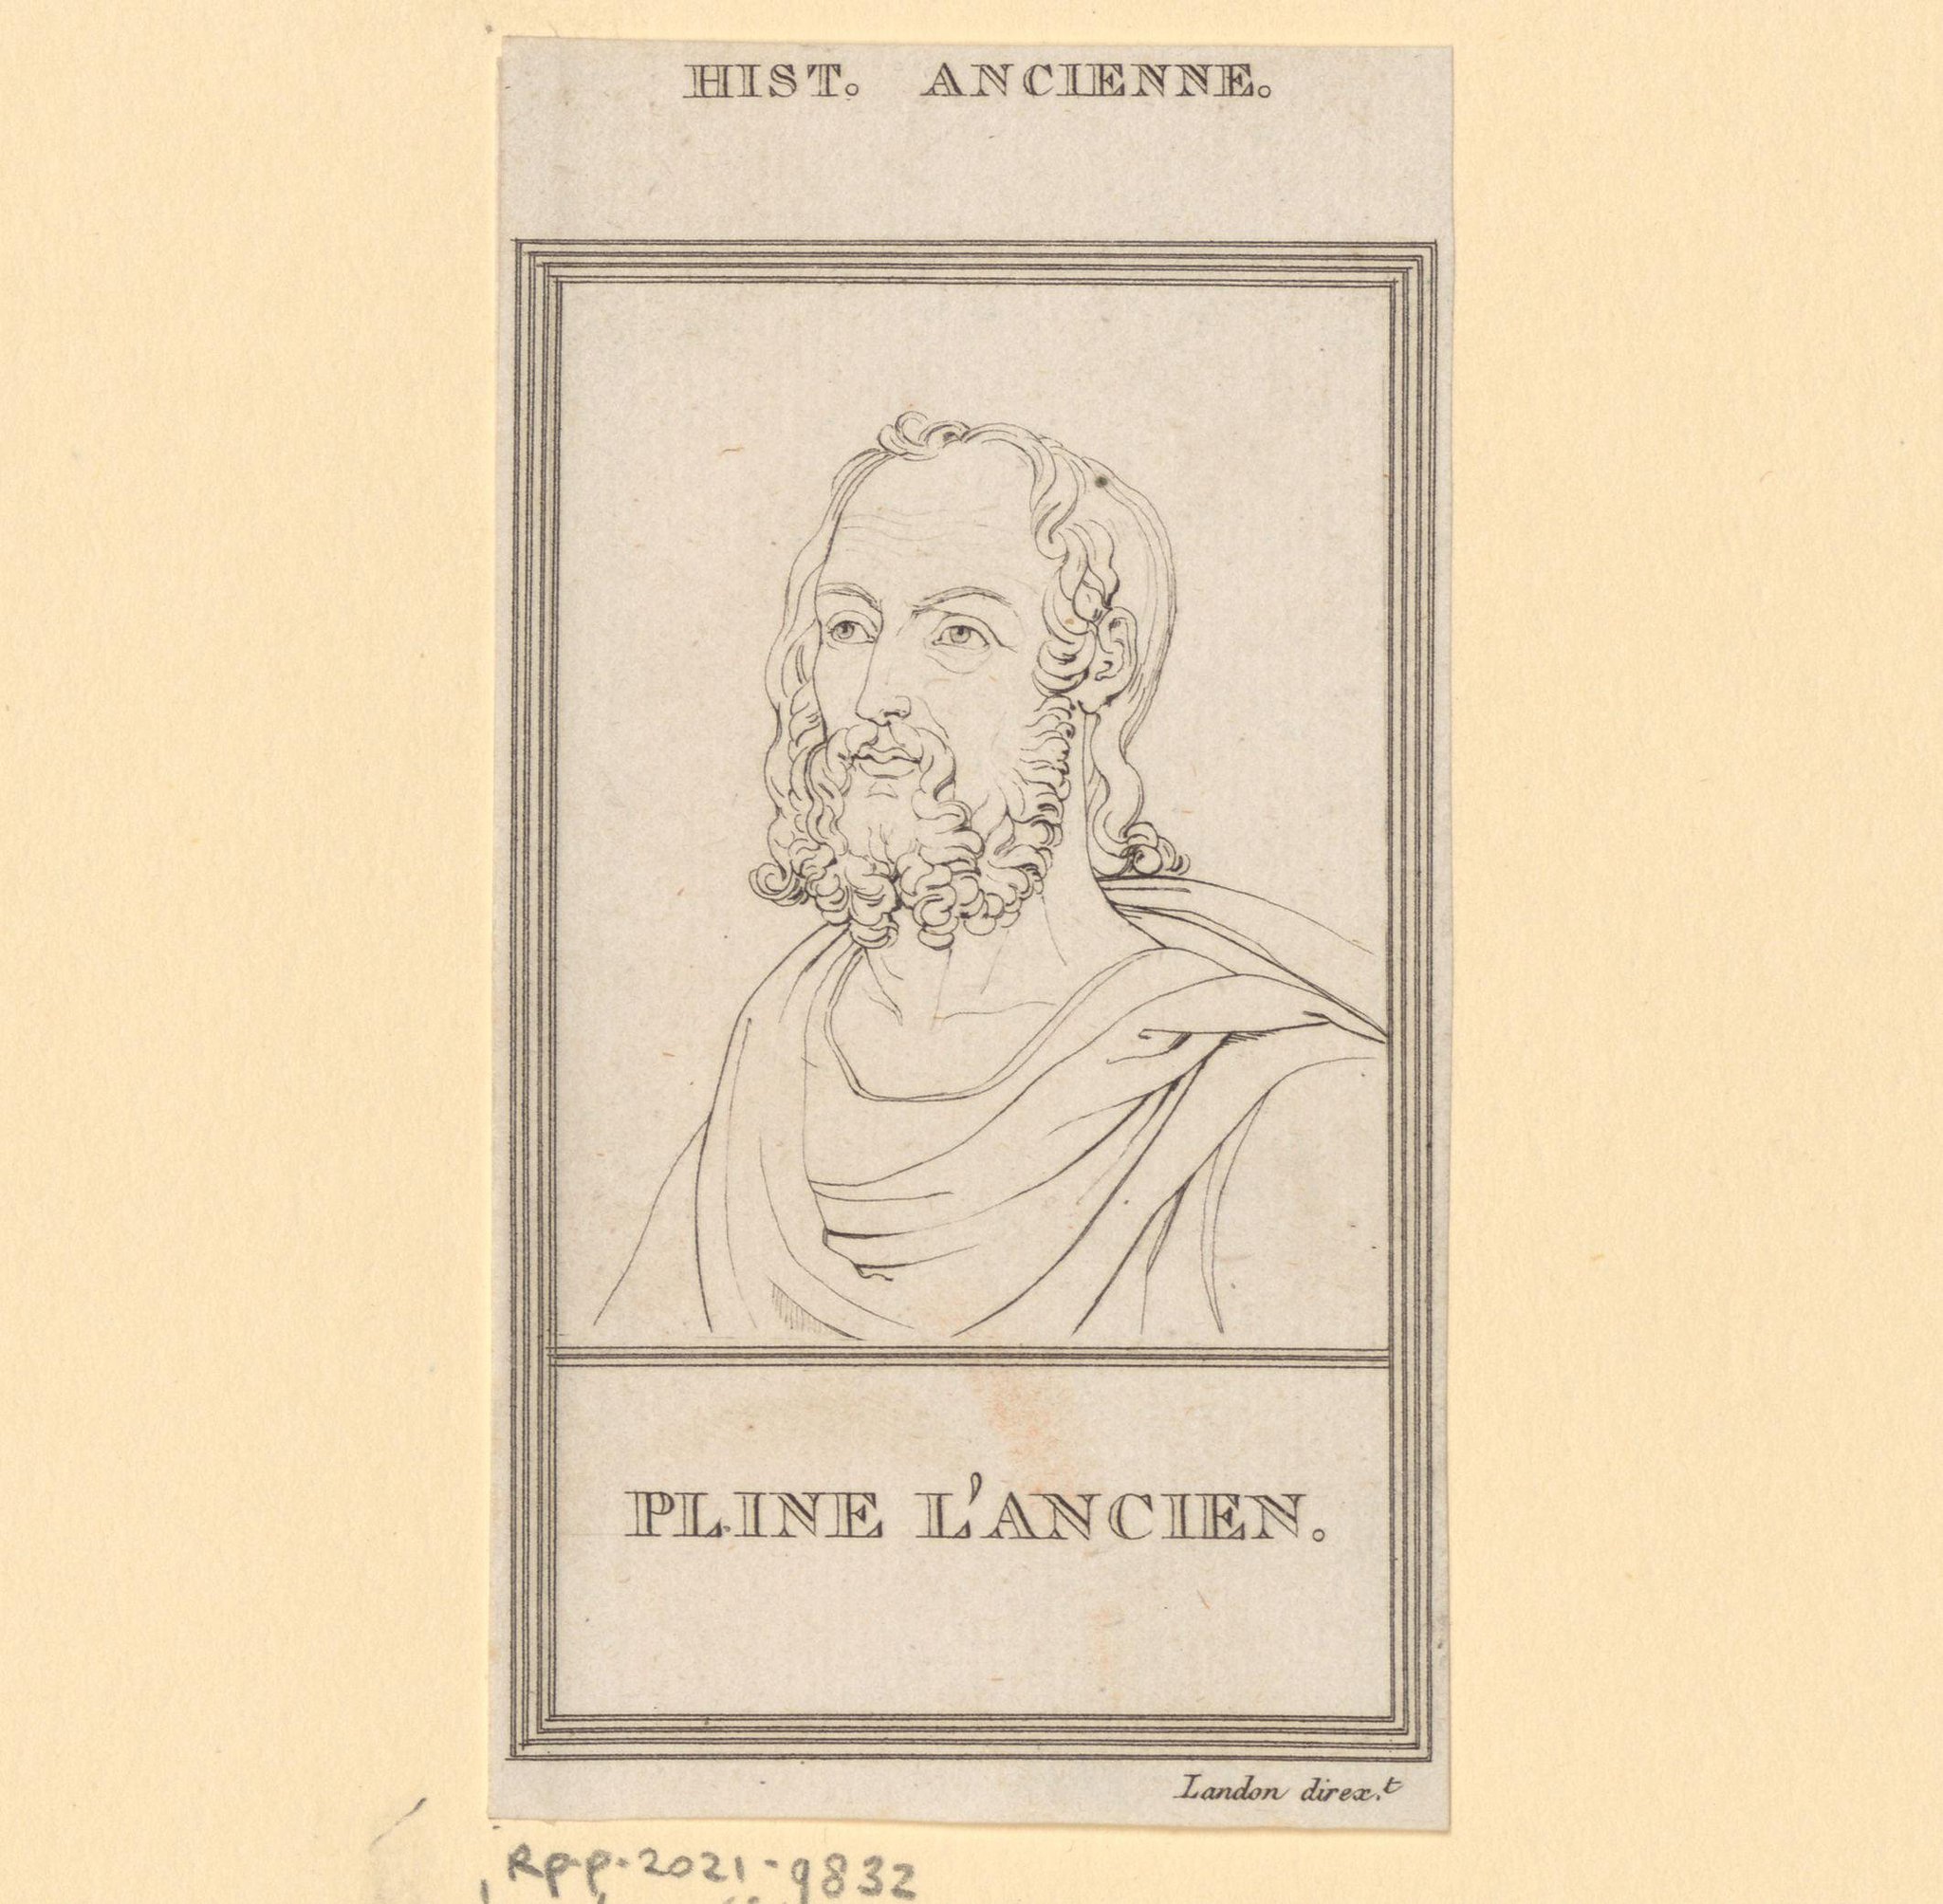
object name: print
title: Portret van Plinius de Oudere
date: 1807-1808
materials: paper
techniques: engraving, etching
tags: adult man, historical persons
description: Prent waarschijnlijk uit: Galerie historique des hommes les plus célèbres (...). Parijs: Charles Paul Landon, 1807, dl. 10. Of uit de editie van 1808.